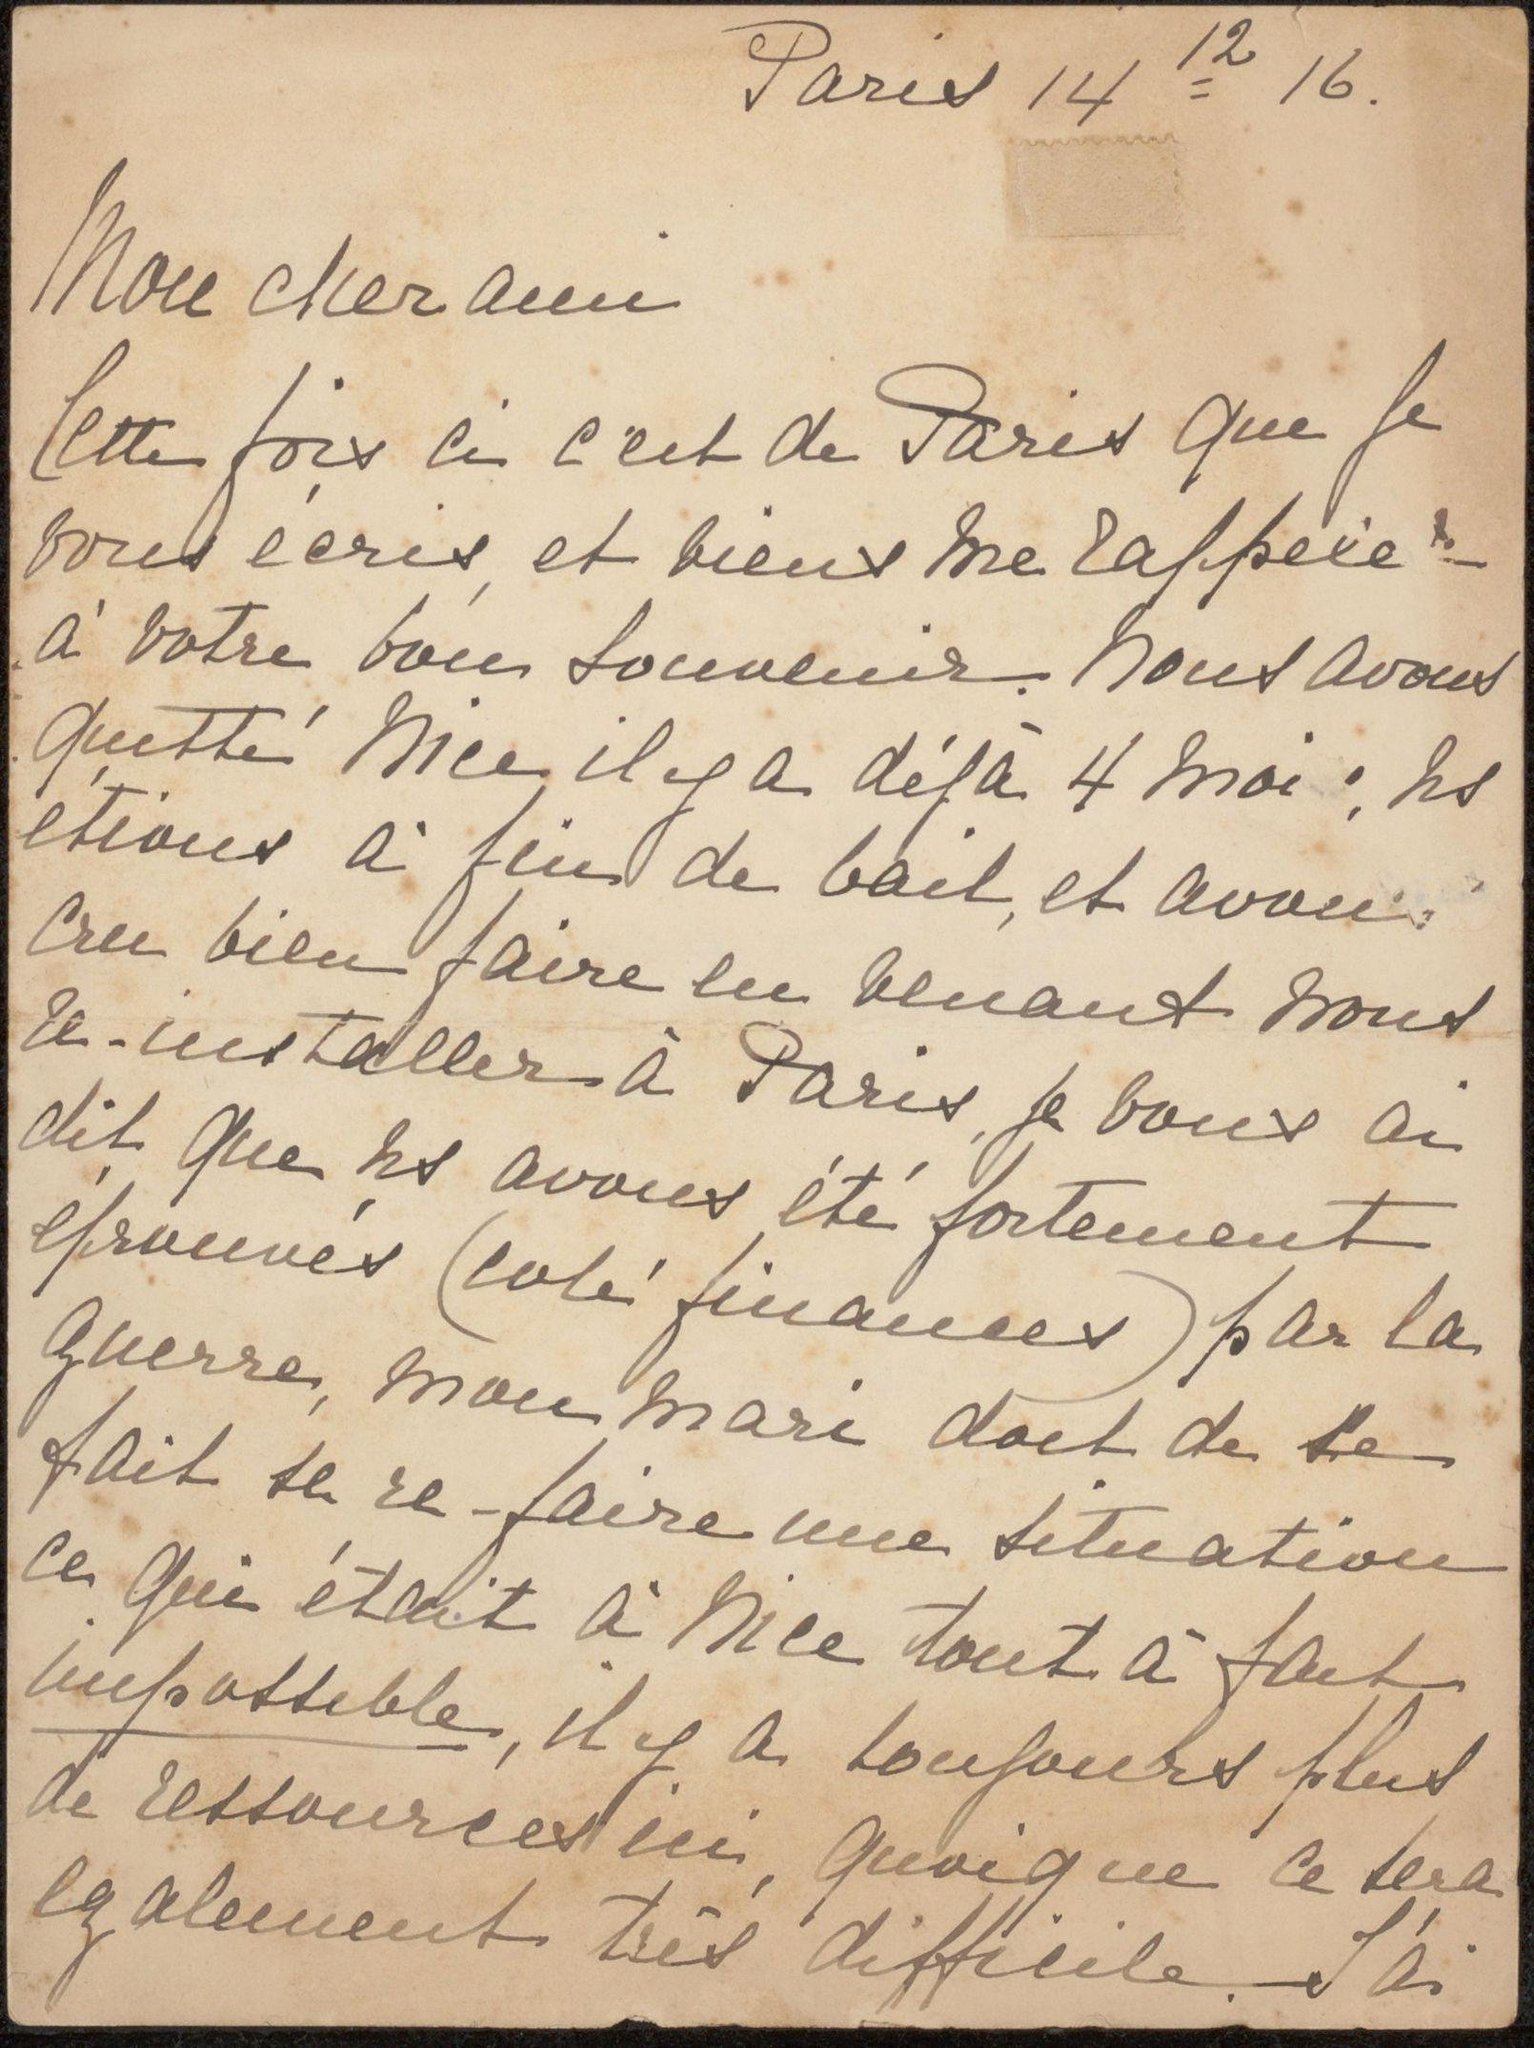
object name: letter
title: Brief aan Philip Zilcken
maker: cato l hôpital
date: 1916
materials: ink, paper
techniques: pen, writing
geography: paris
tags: the hague, painter, draughtsman, philip zilcken, painting (including book-illumination, miniature-painting), paris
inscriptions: collector's mark: ‘RPK’